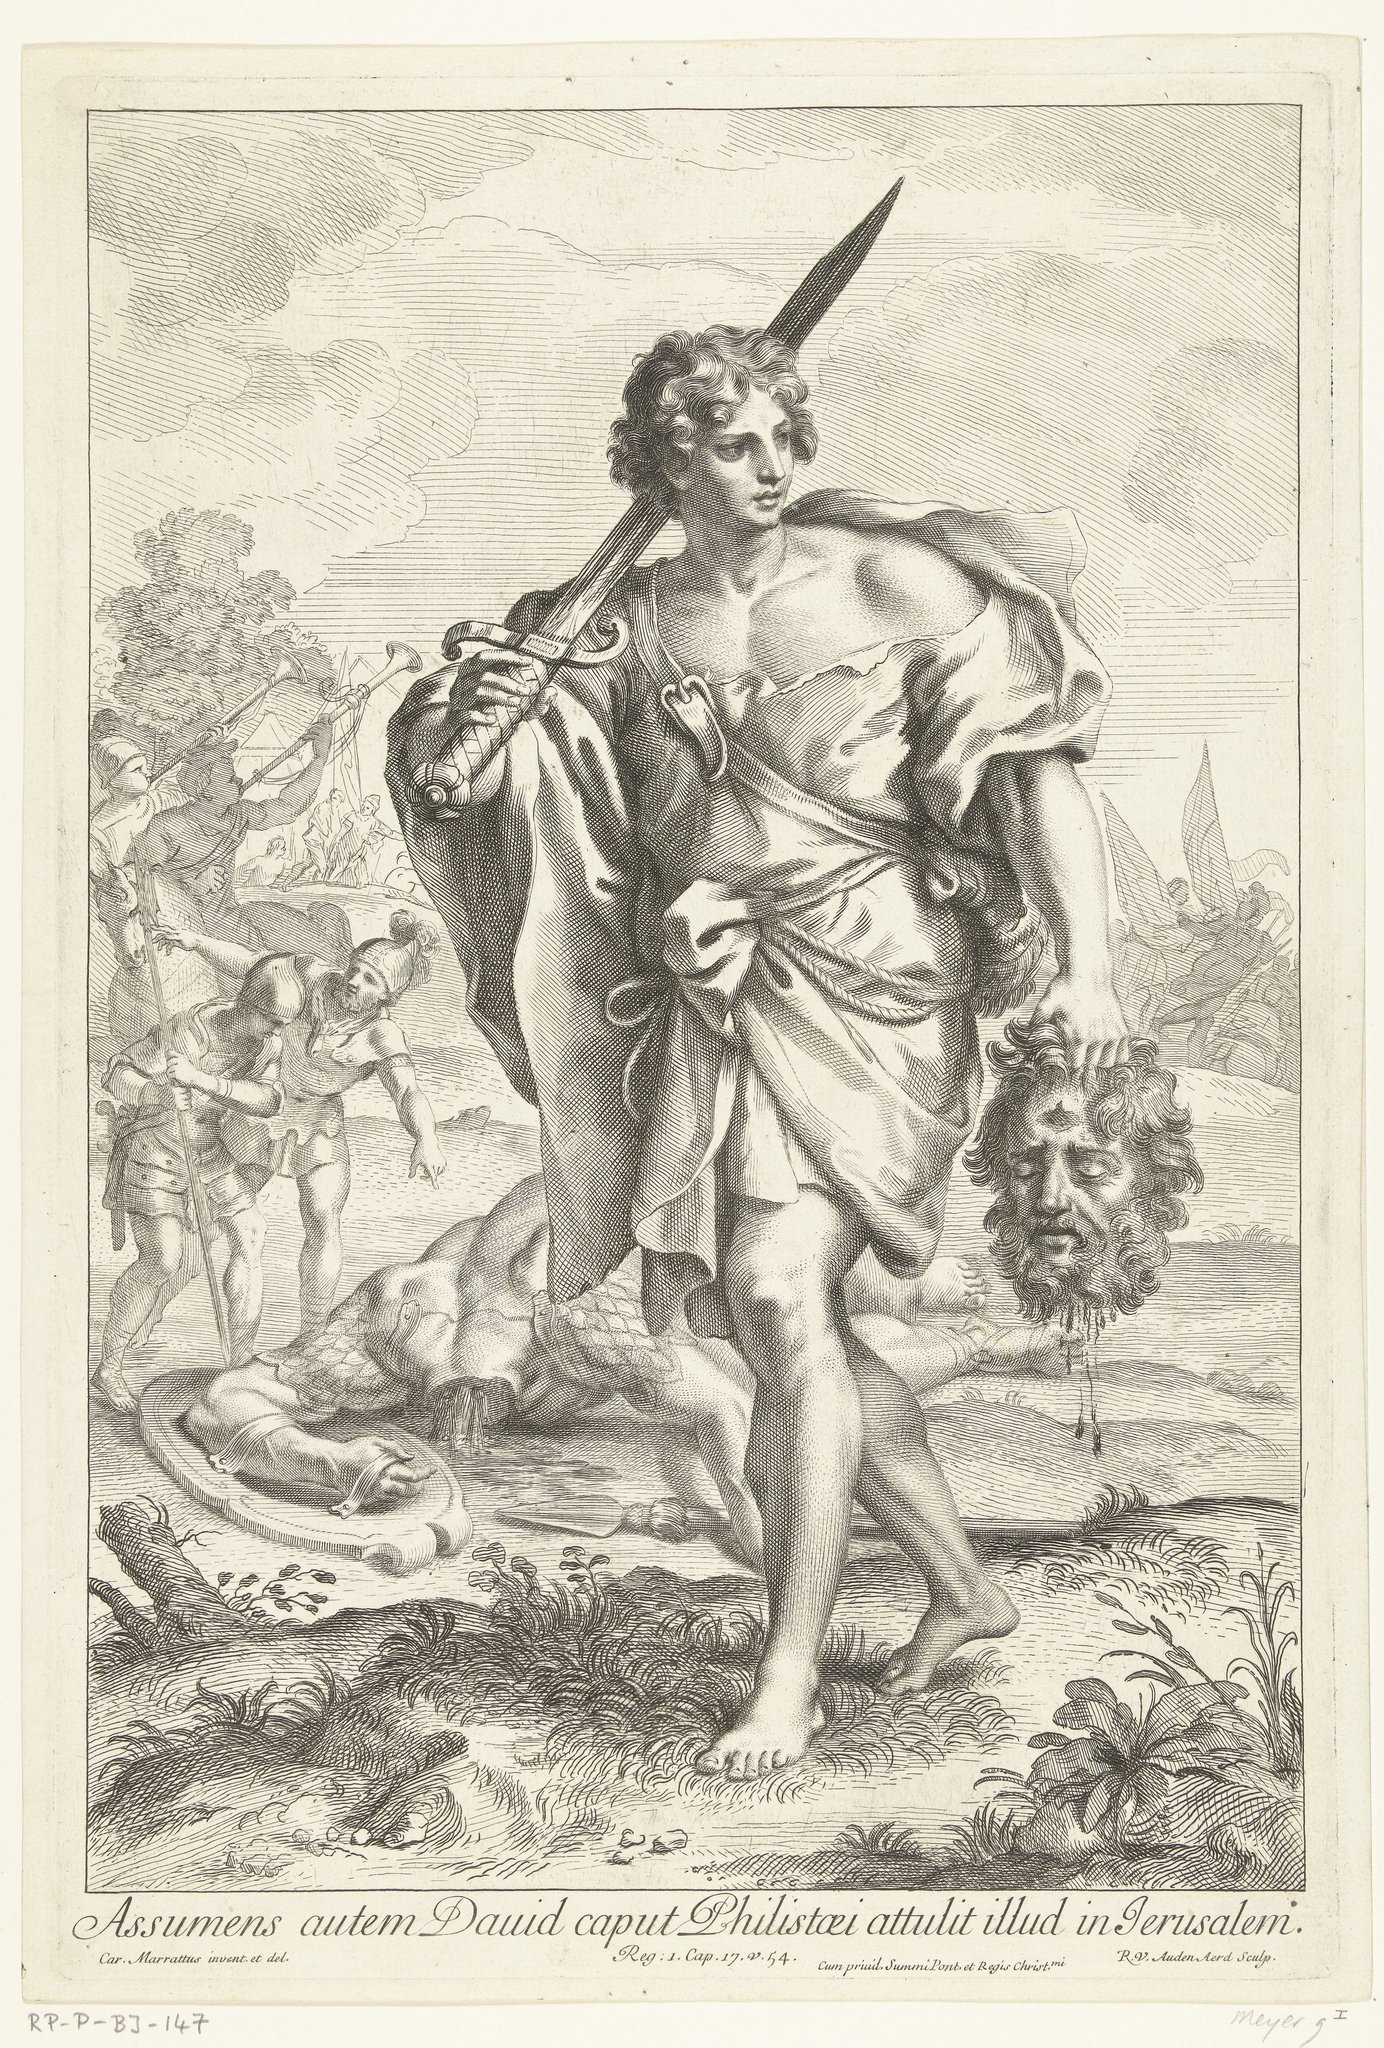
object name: print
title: David met het hoofd van Goliath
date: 1685-1723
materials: paper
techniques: engraving, etching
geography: rome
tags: david with goliath's head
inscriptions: collector's mark: Lugt 240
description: David met zwaard en het hoofd van Goliath in zijn hand. Achter hem ligt de onthoofde Goliath op de grond omringd door soldaten. In de ondermaerge een bijbelvers in het Latijn.